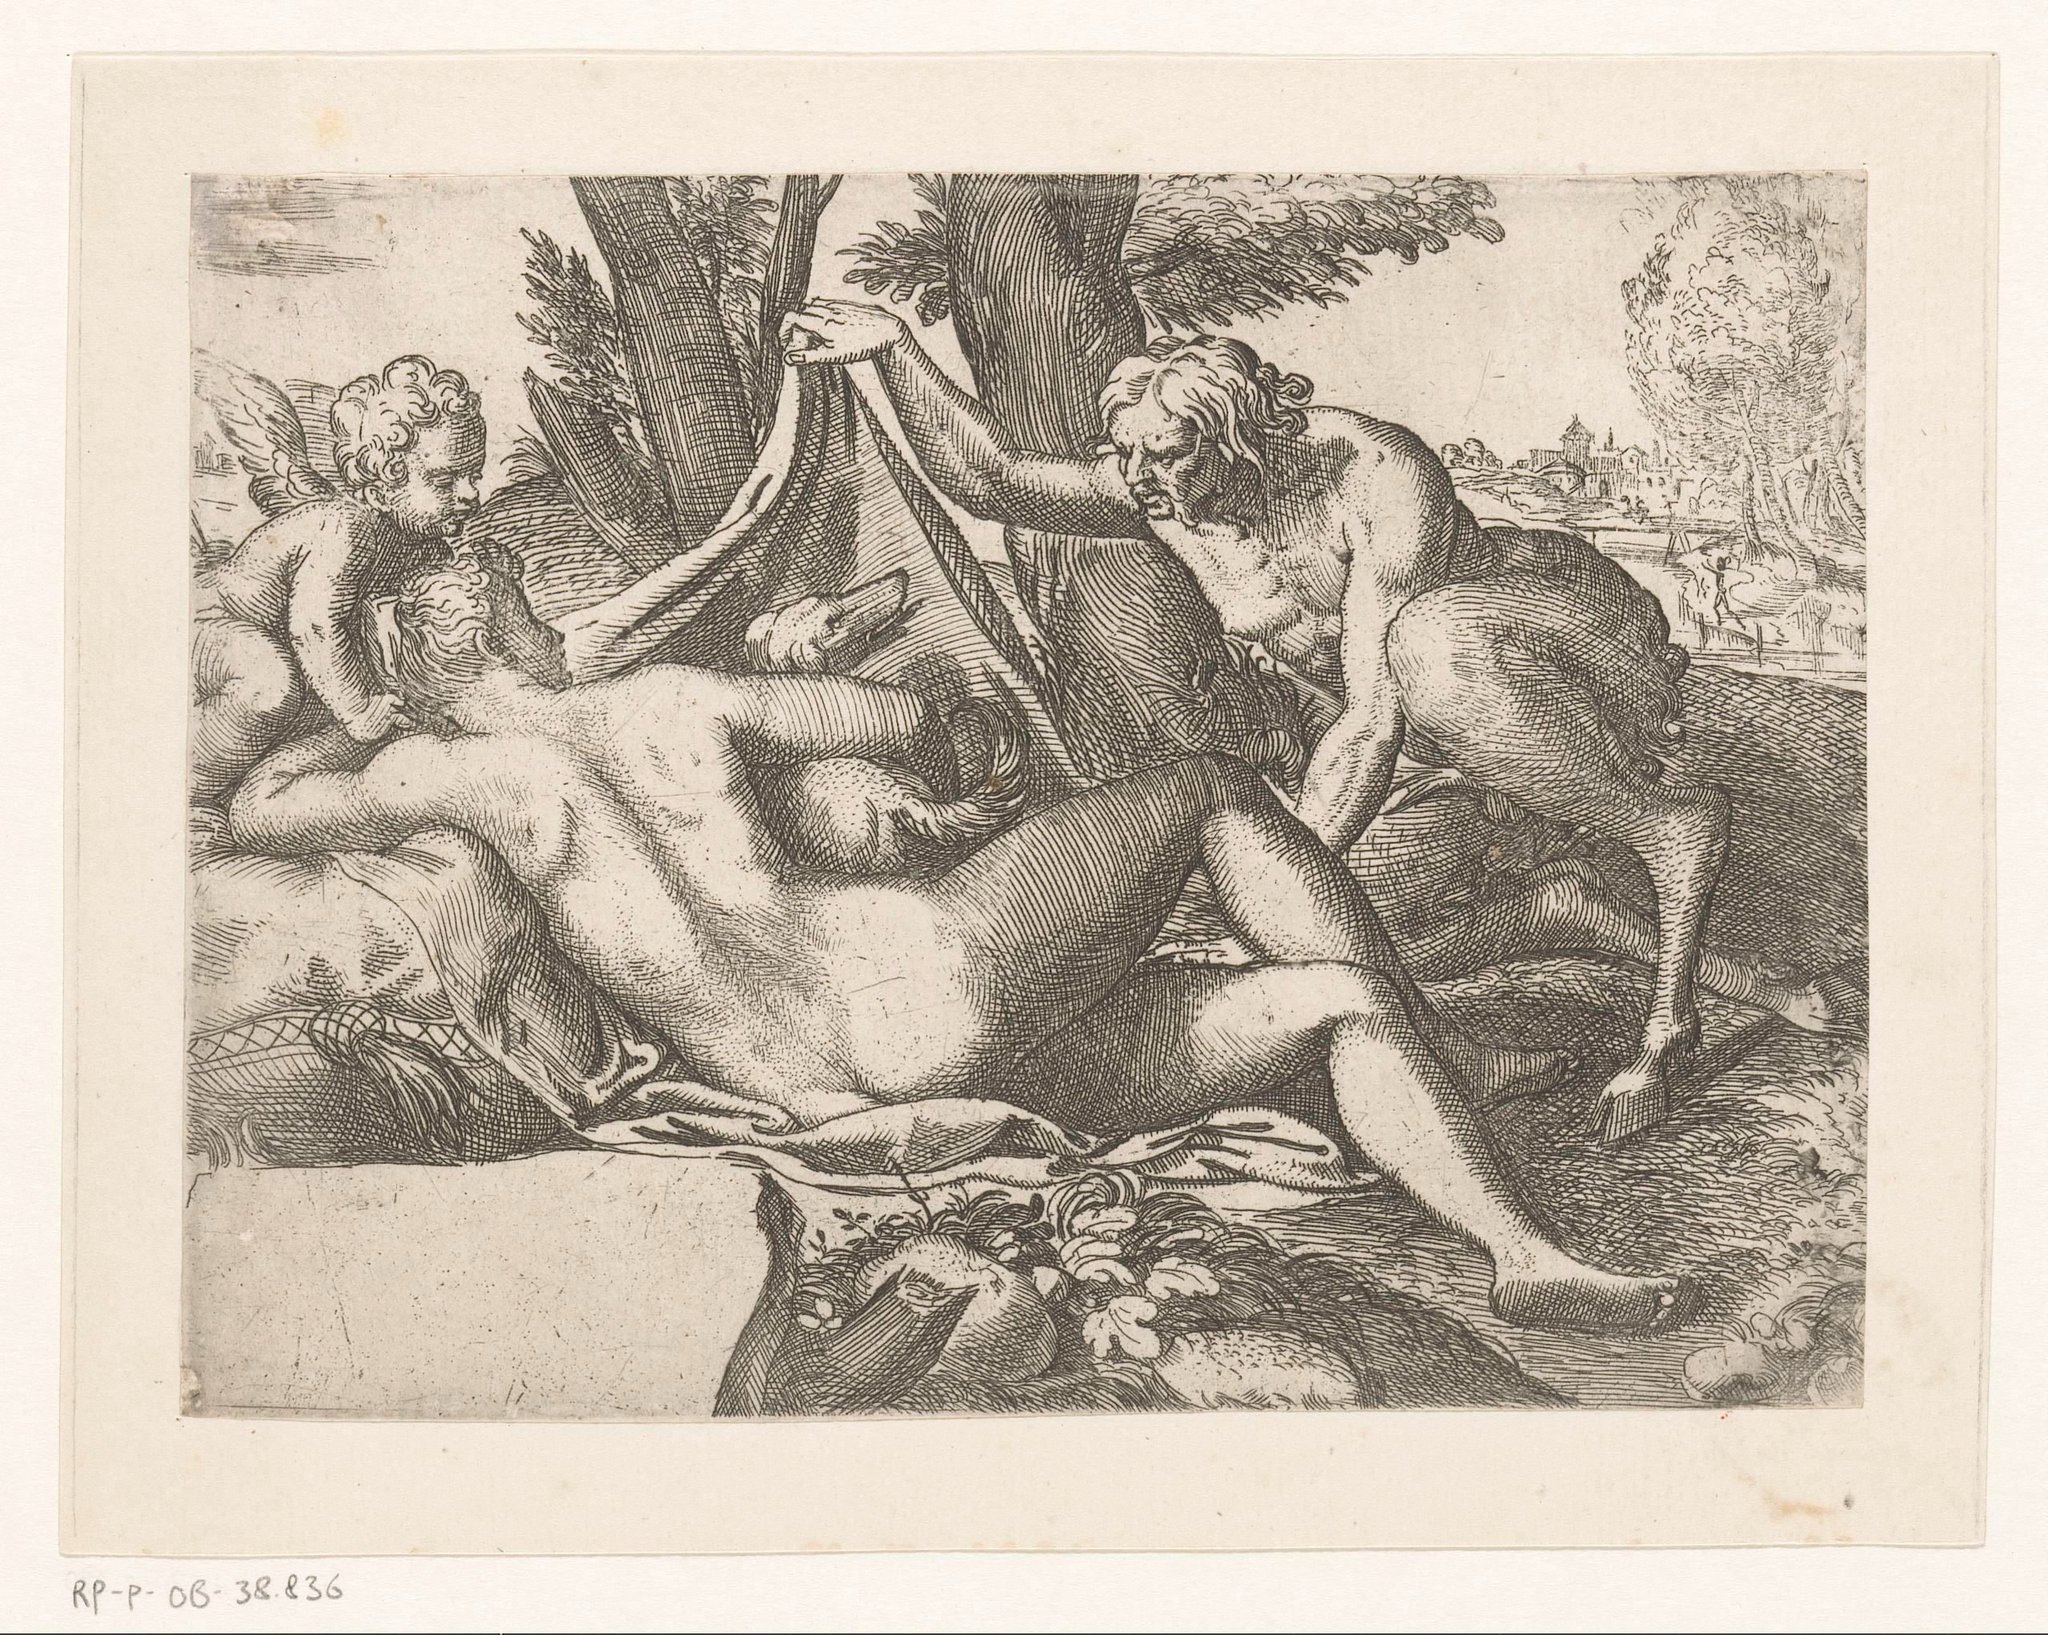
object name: print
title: Slapende Venus bespied door een sater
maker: Anonymous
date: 1550-1649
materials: paper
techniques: engraving, etching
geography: italy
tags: satyr(s) spying upon, venus asleep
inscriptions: inscription: ‘6,1. - 56.’, collector's mark: Lugt 240